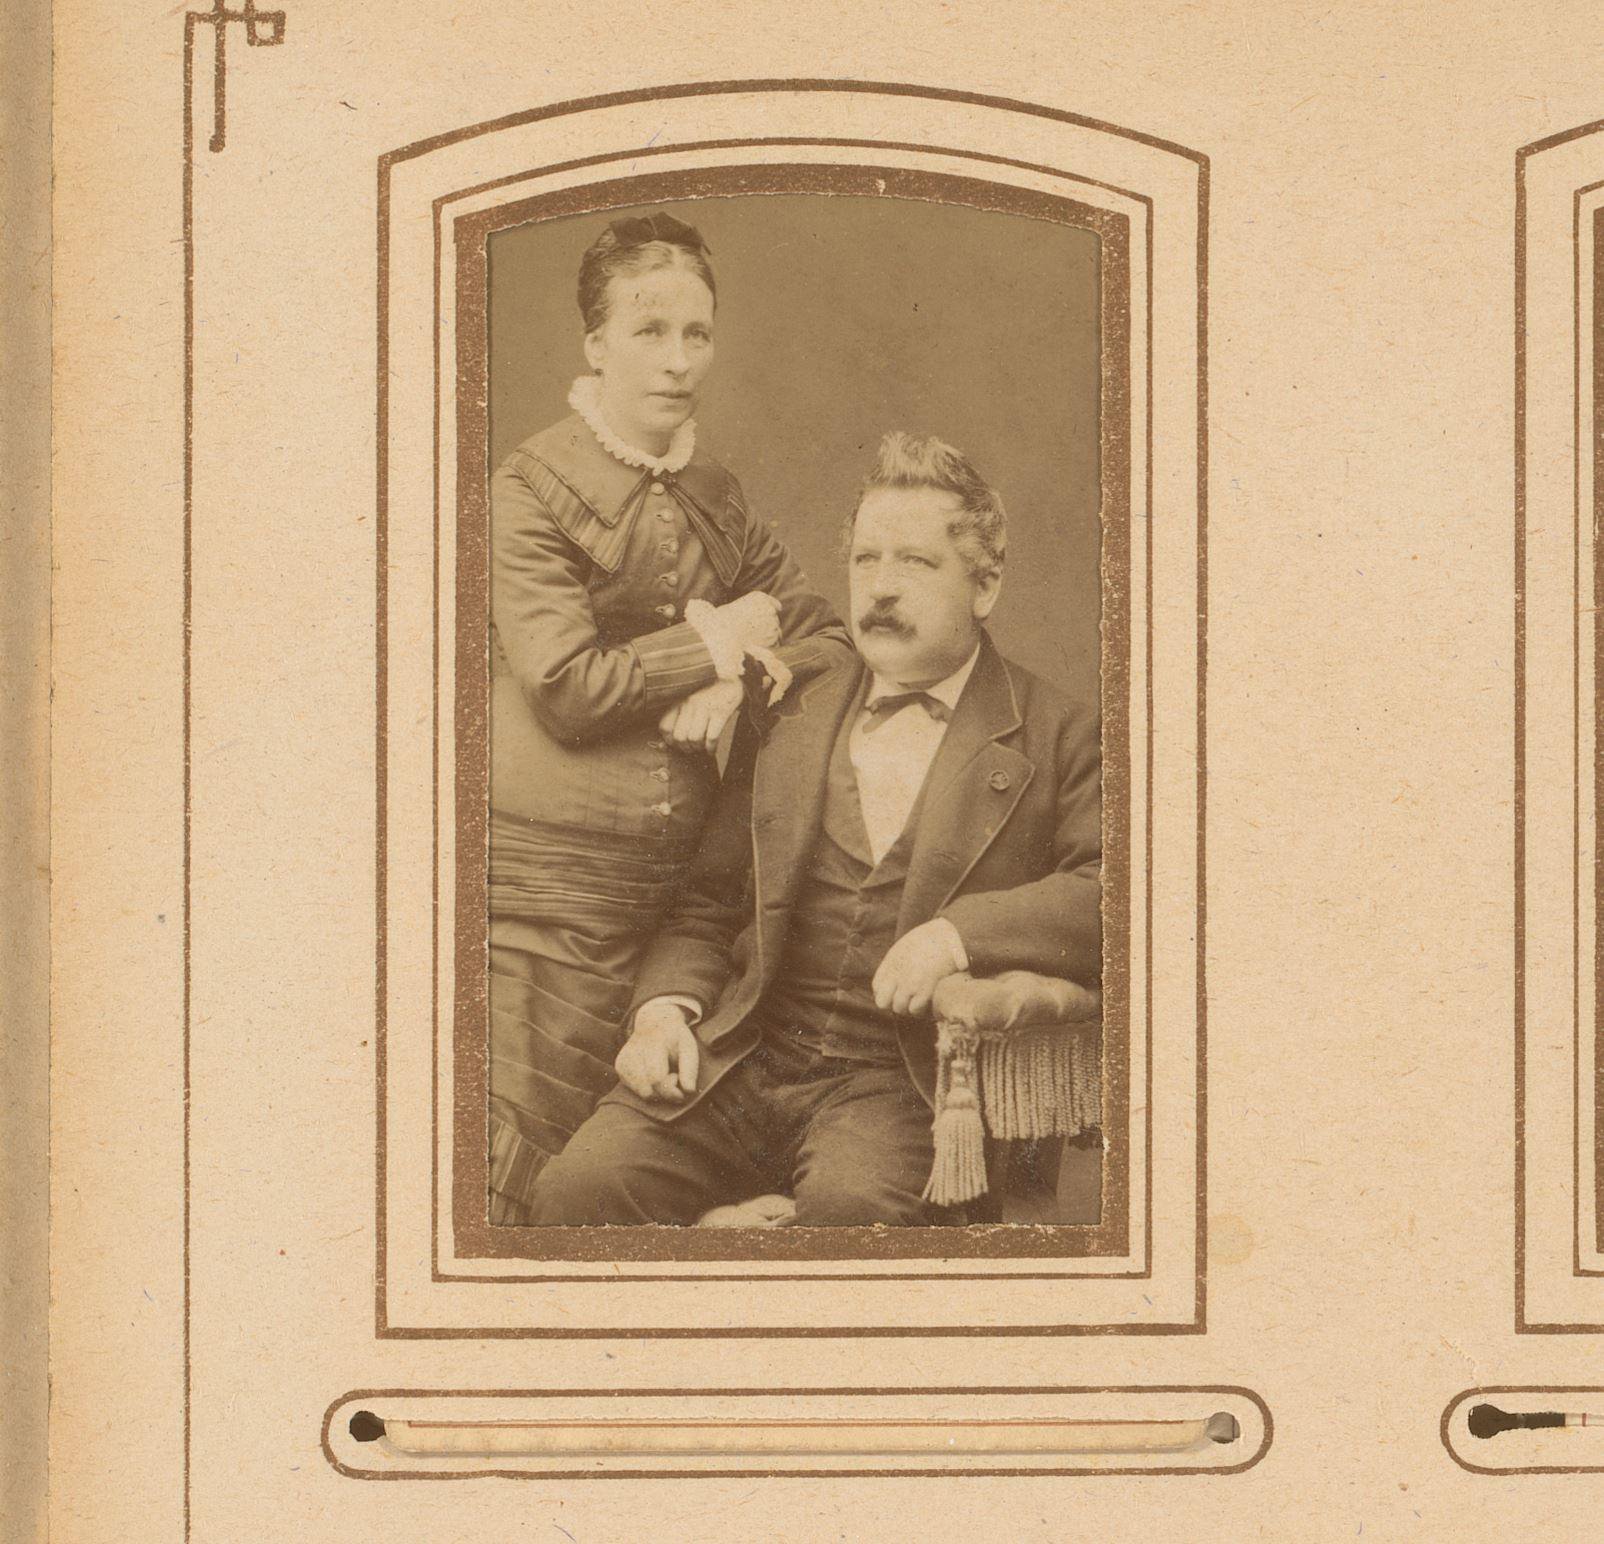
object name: photograph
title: Portret van een man en vrouw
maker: johannes hendrikus kramer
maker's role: fotograaf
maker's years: 1846-1901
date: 1880-1900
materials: cardboard, photographic support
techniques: albumen print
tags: adult woman, adult man, historical persons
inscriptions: inscription: ‘J. H. Kramer/ Mariaplaats naast de Botermarkt/ Utrecht (...)’